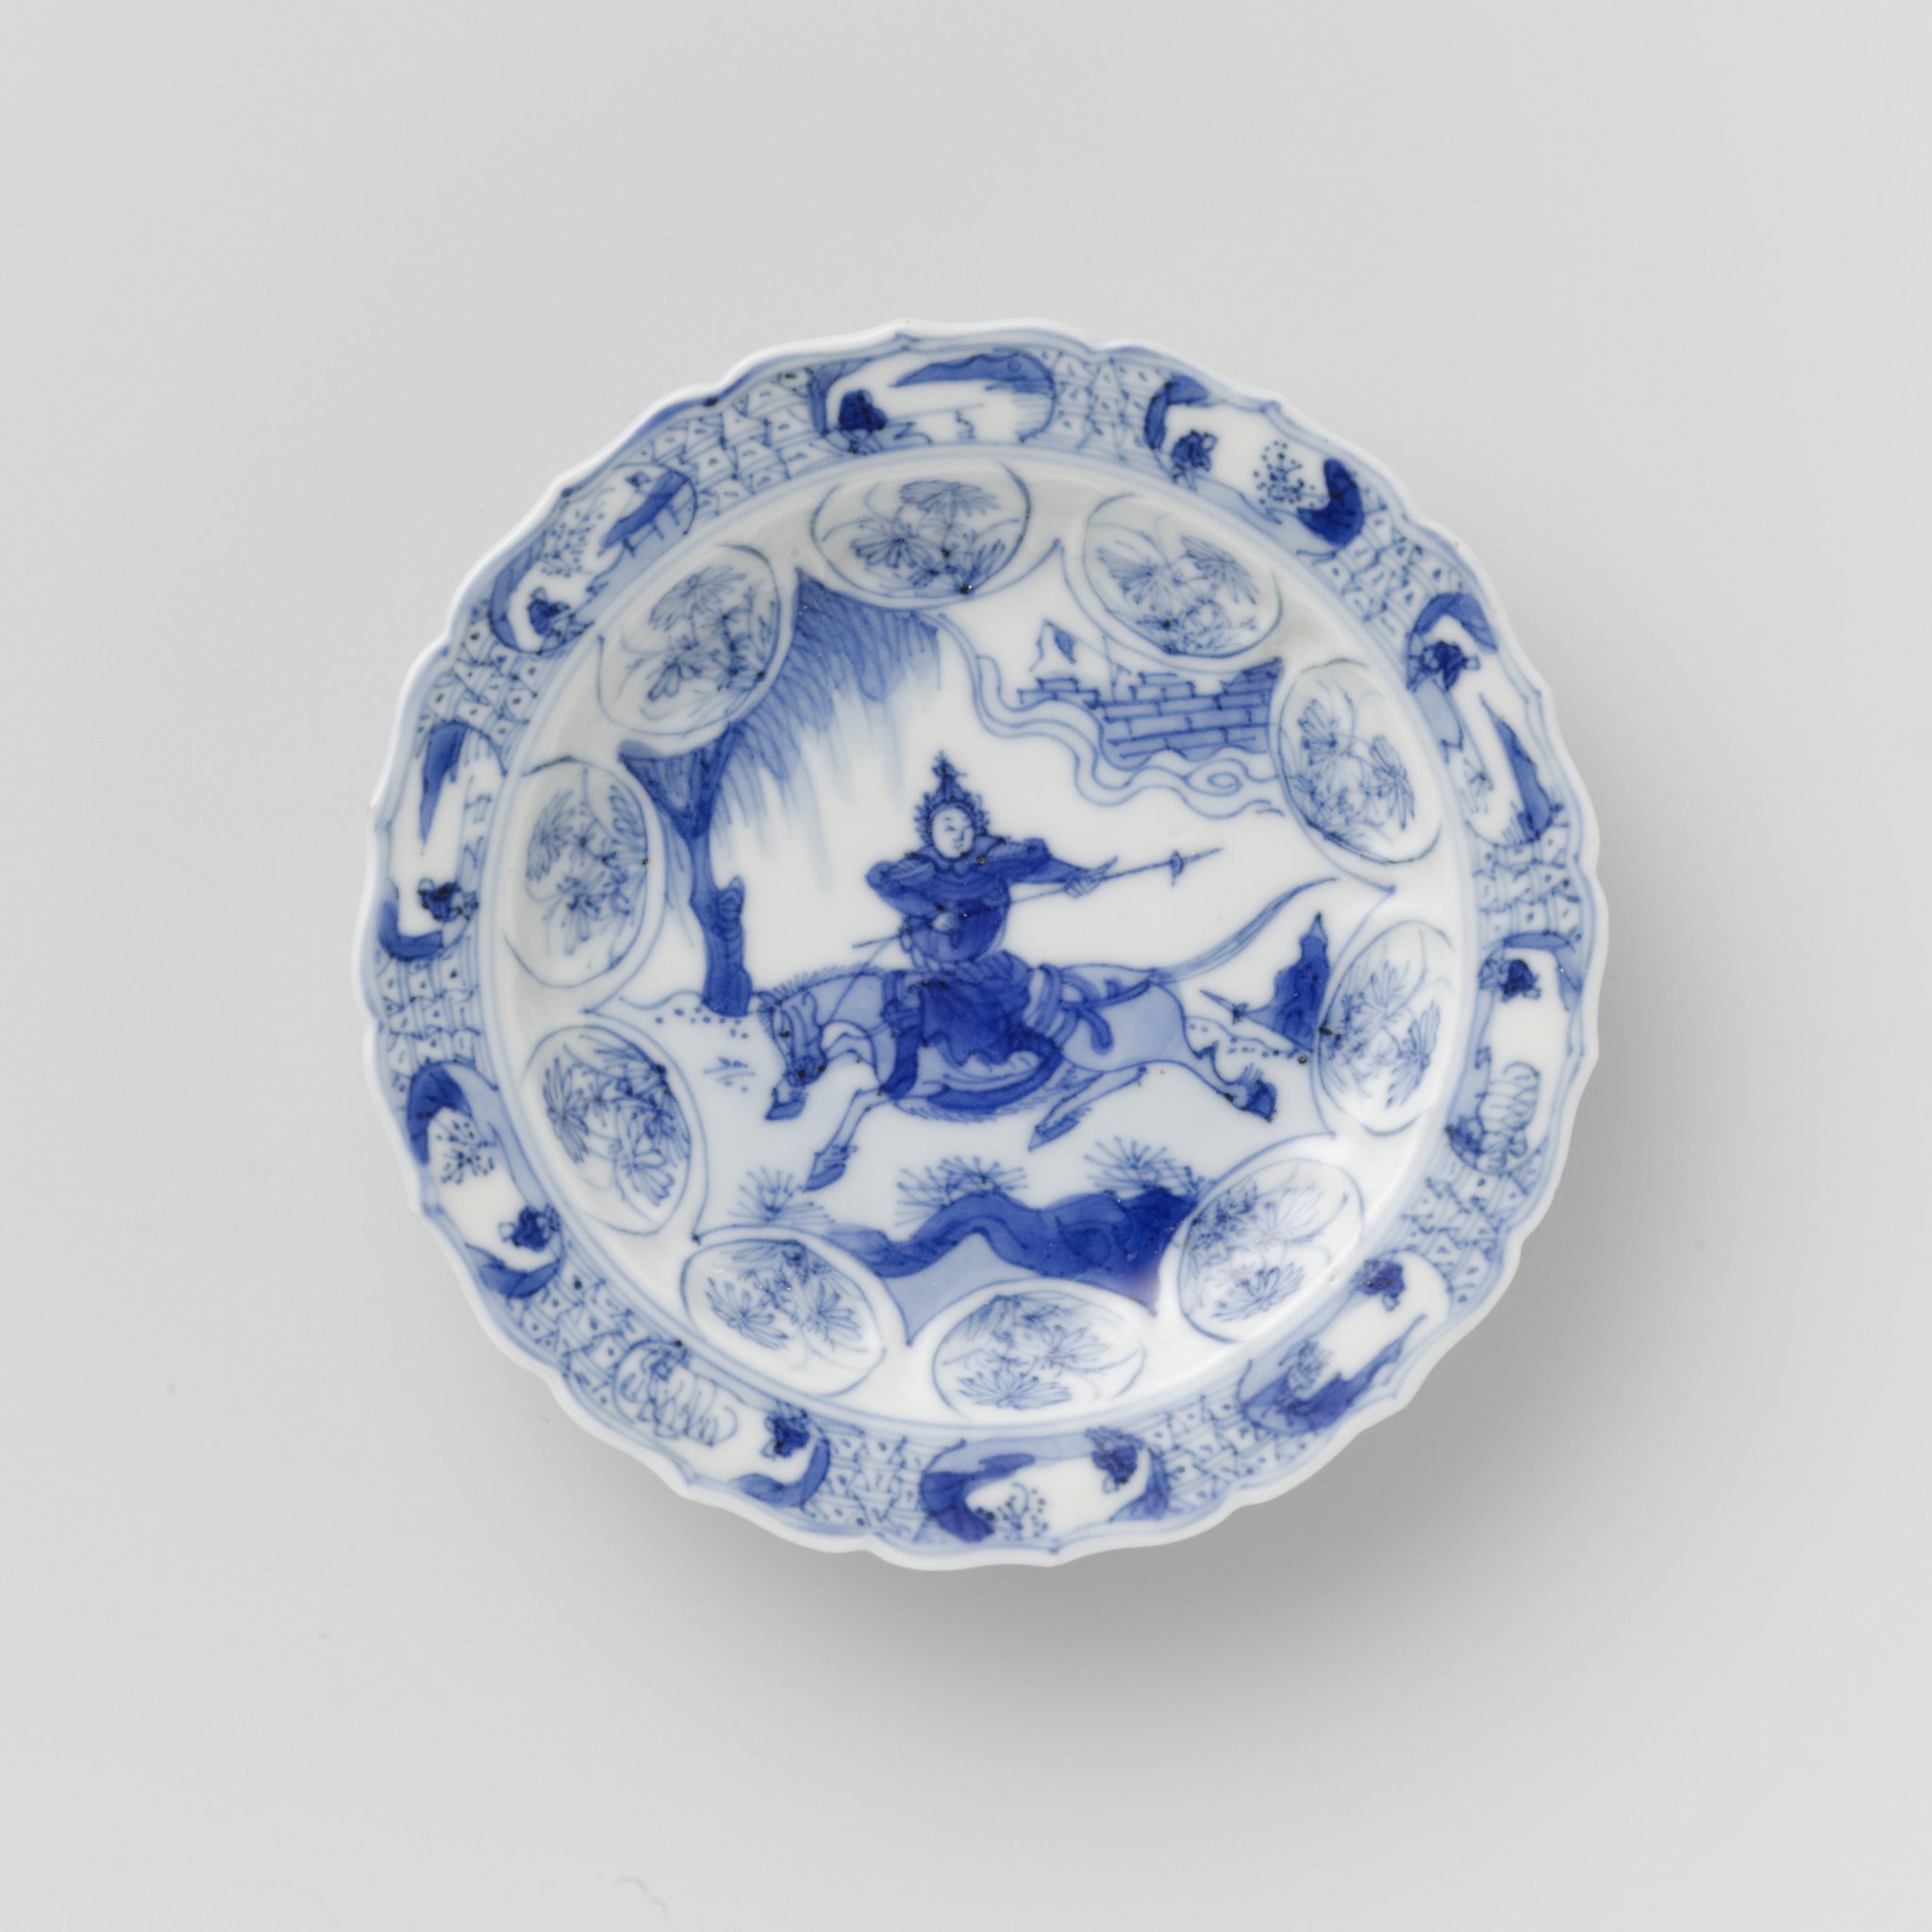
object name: platter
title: Saucer with horsemen, flower sprays and landscapes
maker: Anonymous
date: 1680-1720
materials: cobalt, glaze, paint, porcelain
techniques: firing, turning, vitrification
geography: china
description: AK-NM-6895 en 6896 Kop en schotel • Blauw-wit Kangxi-porselein • Onderdeel van Royers porseleincollectie • Oorspronkelijk acht koppen en zes schotels (inventaris Van der Kellen 1876) Tegenwoordig bevat Royers porseleincollectie nog maar een paar koppen en schotels. Vóór de ruilingen van het begin van de 20ste eeuw waren dat (voor wat betreft het blauw-wit) 77 koppen en 86 schotels. Daarnaast had Rooyer in zijn huis nog verschillende theeserviezen die in het zicht waren opgesteld, als onderdeel van de aankleding van het interieur en grote series theegoed, weggeborgen in kasten voor het dagelijks gebruik. Theegoed was dus bij Royer thuis in grote hoeveelheden aanwezig, veel meer dan redelijkerwijs verwacht kan worden. De aanwezigheid van zoveel theegoed buiten de ‘echte’ porseleincollectie om maakt ook duidelijk dat deze koppen en schotels, in de porseleincollectie, slechts een sierfunctie hadden. De bekende Marot-prenten geven een goede indruk van de manier waarop grote aantallen schoteltjes in een strak ritme op een schoorsteenmantel gemonteerd konden worden (zie bijvoorbeeld RP-P-1964-3048). De grote aantallen waren vrij gebruikelijk. De overvloed aan koppen en schotels aan boord van de gezonken Ca Mau (ca. 1725) geven een indruk van die aantallen [Made in imperial China 2007]. Het zijn er veel meer dan aan boord van de Vung Tau (ca. 1690) – misschien was de mode voor uitzonderlijke grote aantallen theegoed in 1690 nog niet volledig tot ontwikkeling gekomen, al zijn de scheepsladingen natuurlijk incidentele vrachten die geen pertinent beeld van de vraag en aanbod van het moment geven. De ladinglijsten van de gewezen gouverneur-generaal Adriaan Valckenier (1695-1751) bevestigen in ieder geval het beeld van een porseleinkopgekte aan het begin van de 18de eeuw. Valckenier voer in 1741 met zijn persoonlijke bezittingen terug vanuit Azië naar Nederland. De reis verliep niet naar wens. Zelf werd hij gearresteerd vanwege de chaos die een jaar eerder in Batavia was ontstaan en door hem niet was beheerst. Duizenden Chinezen waren vermoord omdat de Nederlandse inwoners van de stad zich door hen bedreigd voelden. Valckenier verdween in de gevangenis, het schip met zijn bezittingen voer verder naar Nederland, maar verging. Wat rest zijn de ladinglijsten en daaruit blijkt dat hij 1474 stuks theegoed met zijn familiewapen mee naar huis nam [Kroes 1998, pp. 32-33]. Deze uitweiding heeft slechts als doel duidelijk te maken dat welgestelde Nederlanders vaak over veel meer theekopjes beschikten dan zij nodig hadden. Deze kop en schotel is fraai gevormd en beschilderd. De ruiter doet denken aan die in de schotel AK-NM-6854, maar hier is natuurlijk nog sterker sprake van een herhaald en geïsoleerd motief en minder van een verhalende voorstelling. Vergelijkbare koppen komen voor op het schilderij dat voorheen werd toegeschreven aan Nicolaas Verkolje (ca. 1715) in het V&A, zie de toelichting bij AK-NM-6851. Bronnen: The Vung Tau Cargo. Chinese Export Porcelain. Veilingcat. Christie’s Amsterdam, 7-8 april 1992. Jochem Kroes, ‘De wapenserviezen van Adriaan Valckenier (16950-1751)’, Vormen uit Vuur 164 (1998-2), pp. 30-43. Christiaan J.A. Jörg en Michael Flecker, Porcelain from the Vung tau wreck. The Hallstrom Excavation, Singapore, 2001. Made in Imperial China; 76,000 pieces of Chinese export porcelain from the Ca mau shipwreck, circa 1725. Veilingcat. Sotheby’s Amsterdam, 29-31 januari 2007.